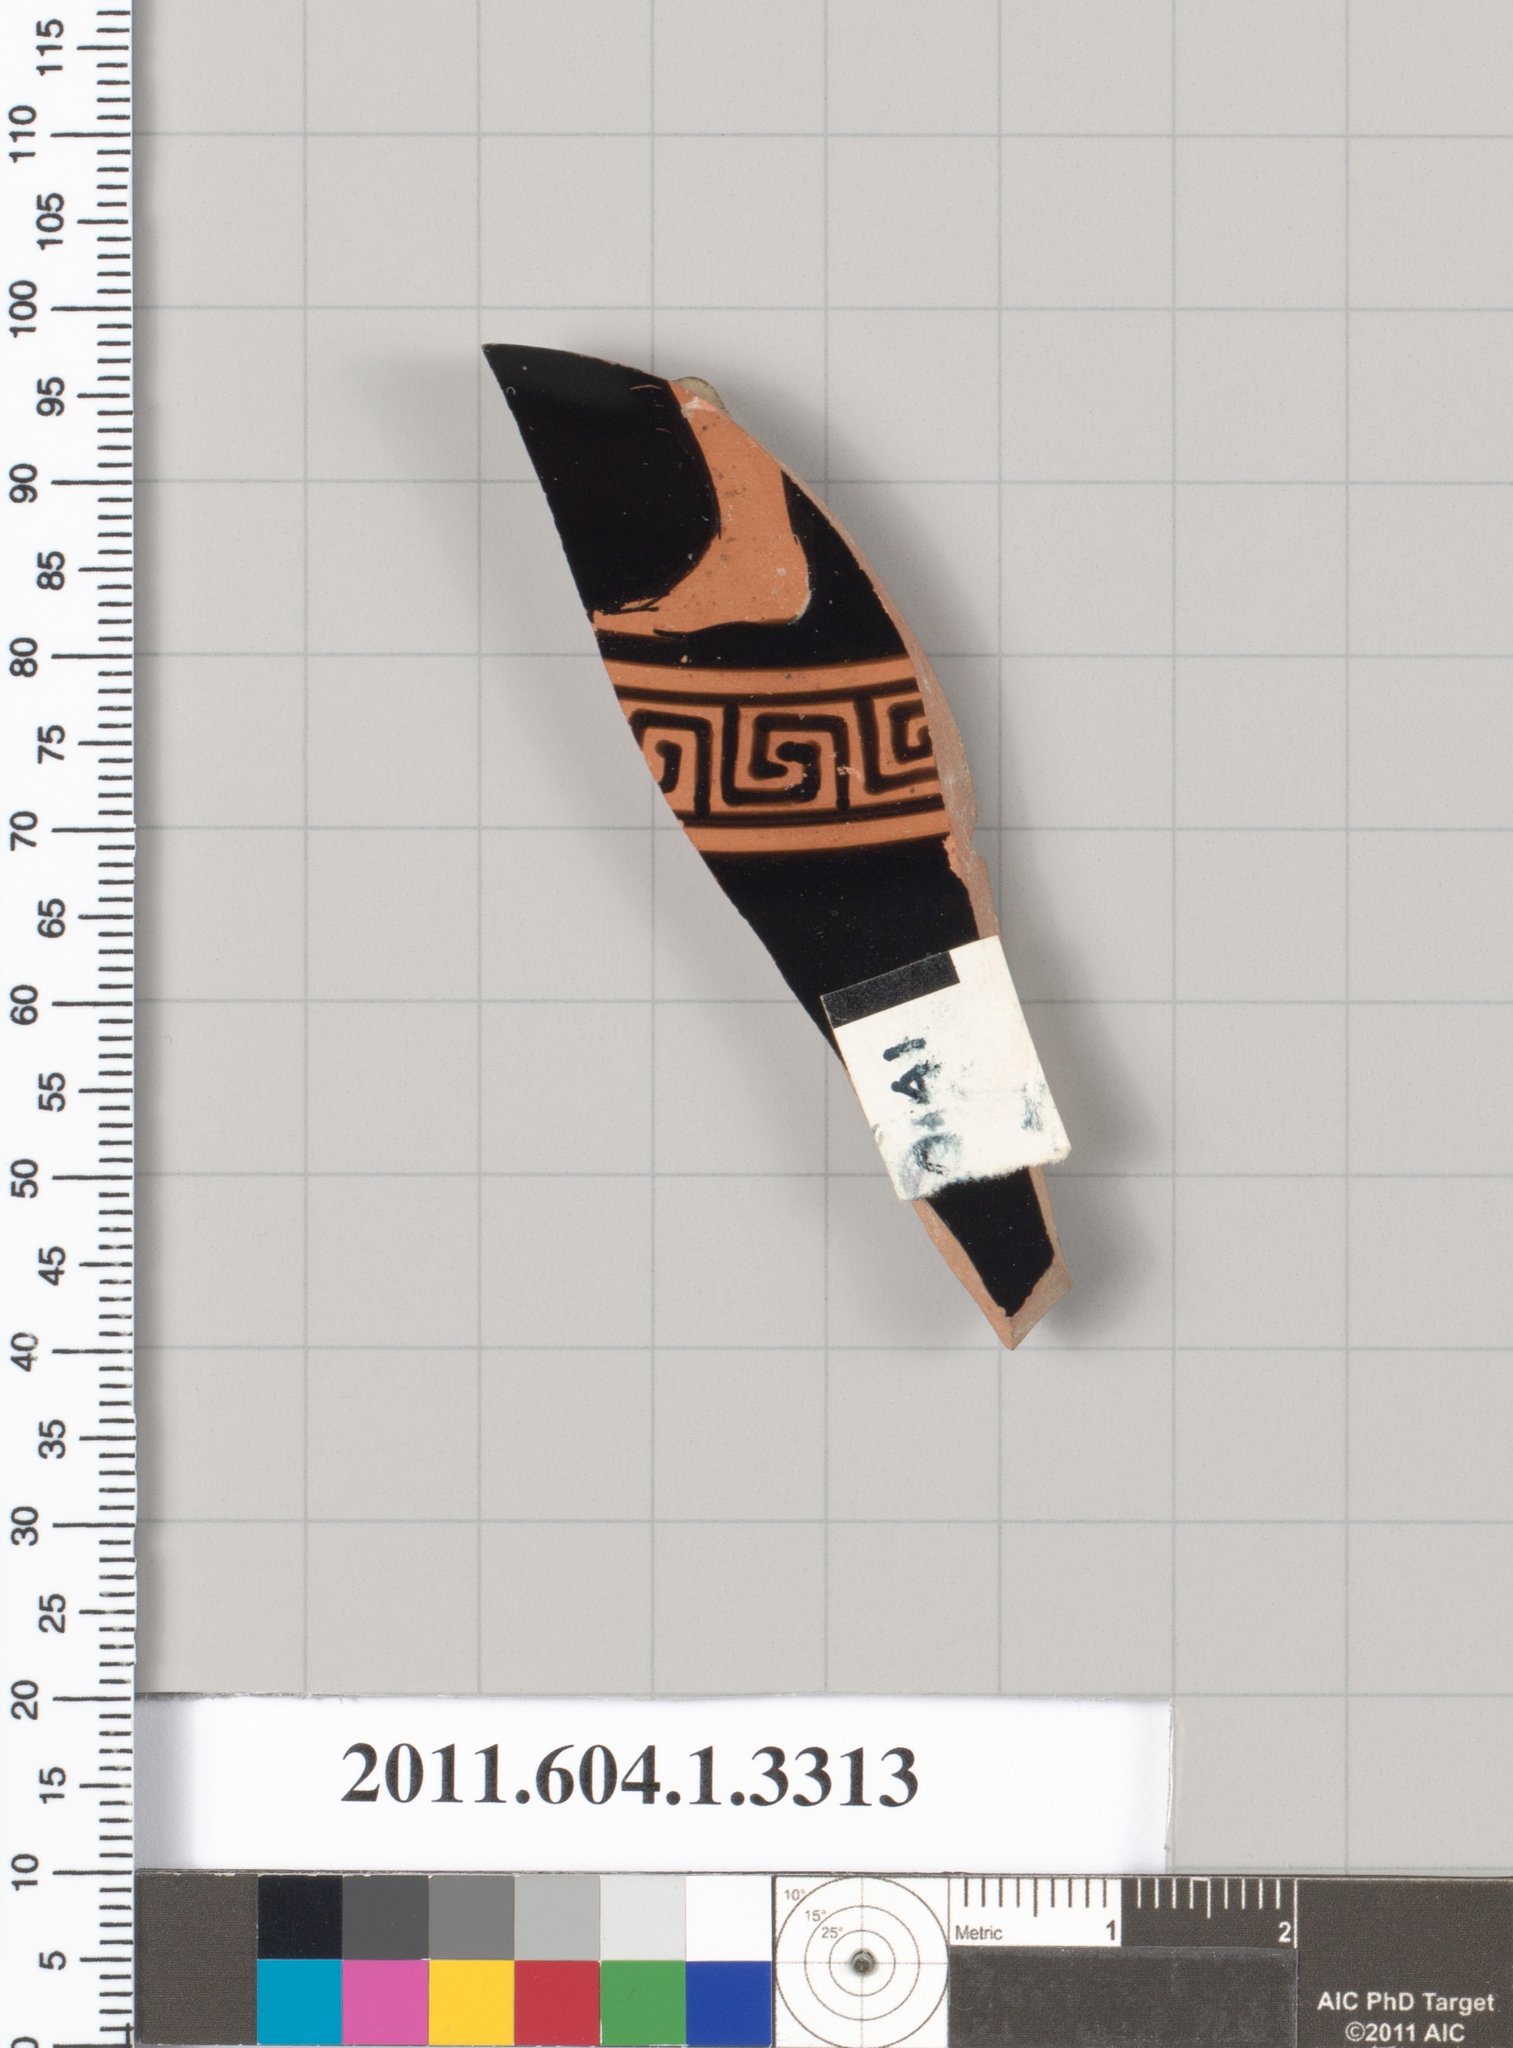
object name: kylix fragment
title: Terracotta fragment of a kylix (drinking cup)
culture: greek, attic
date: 500-480 BCE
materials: terracotta